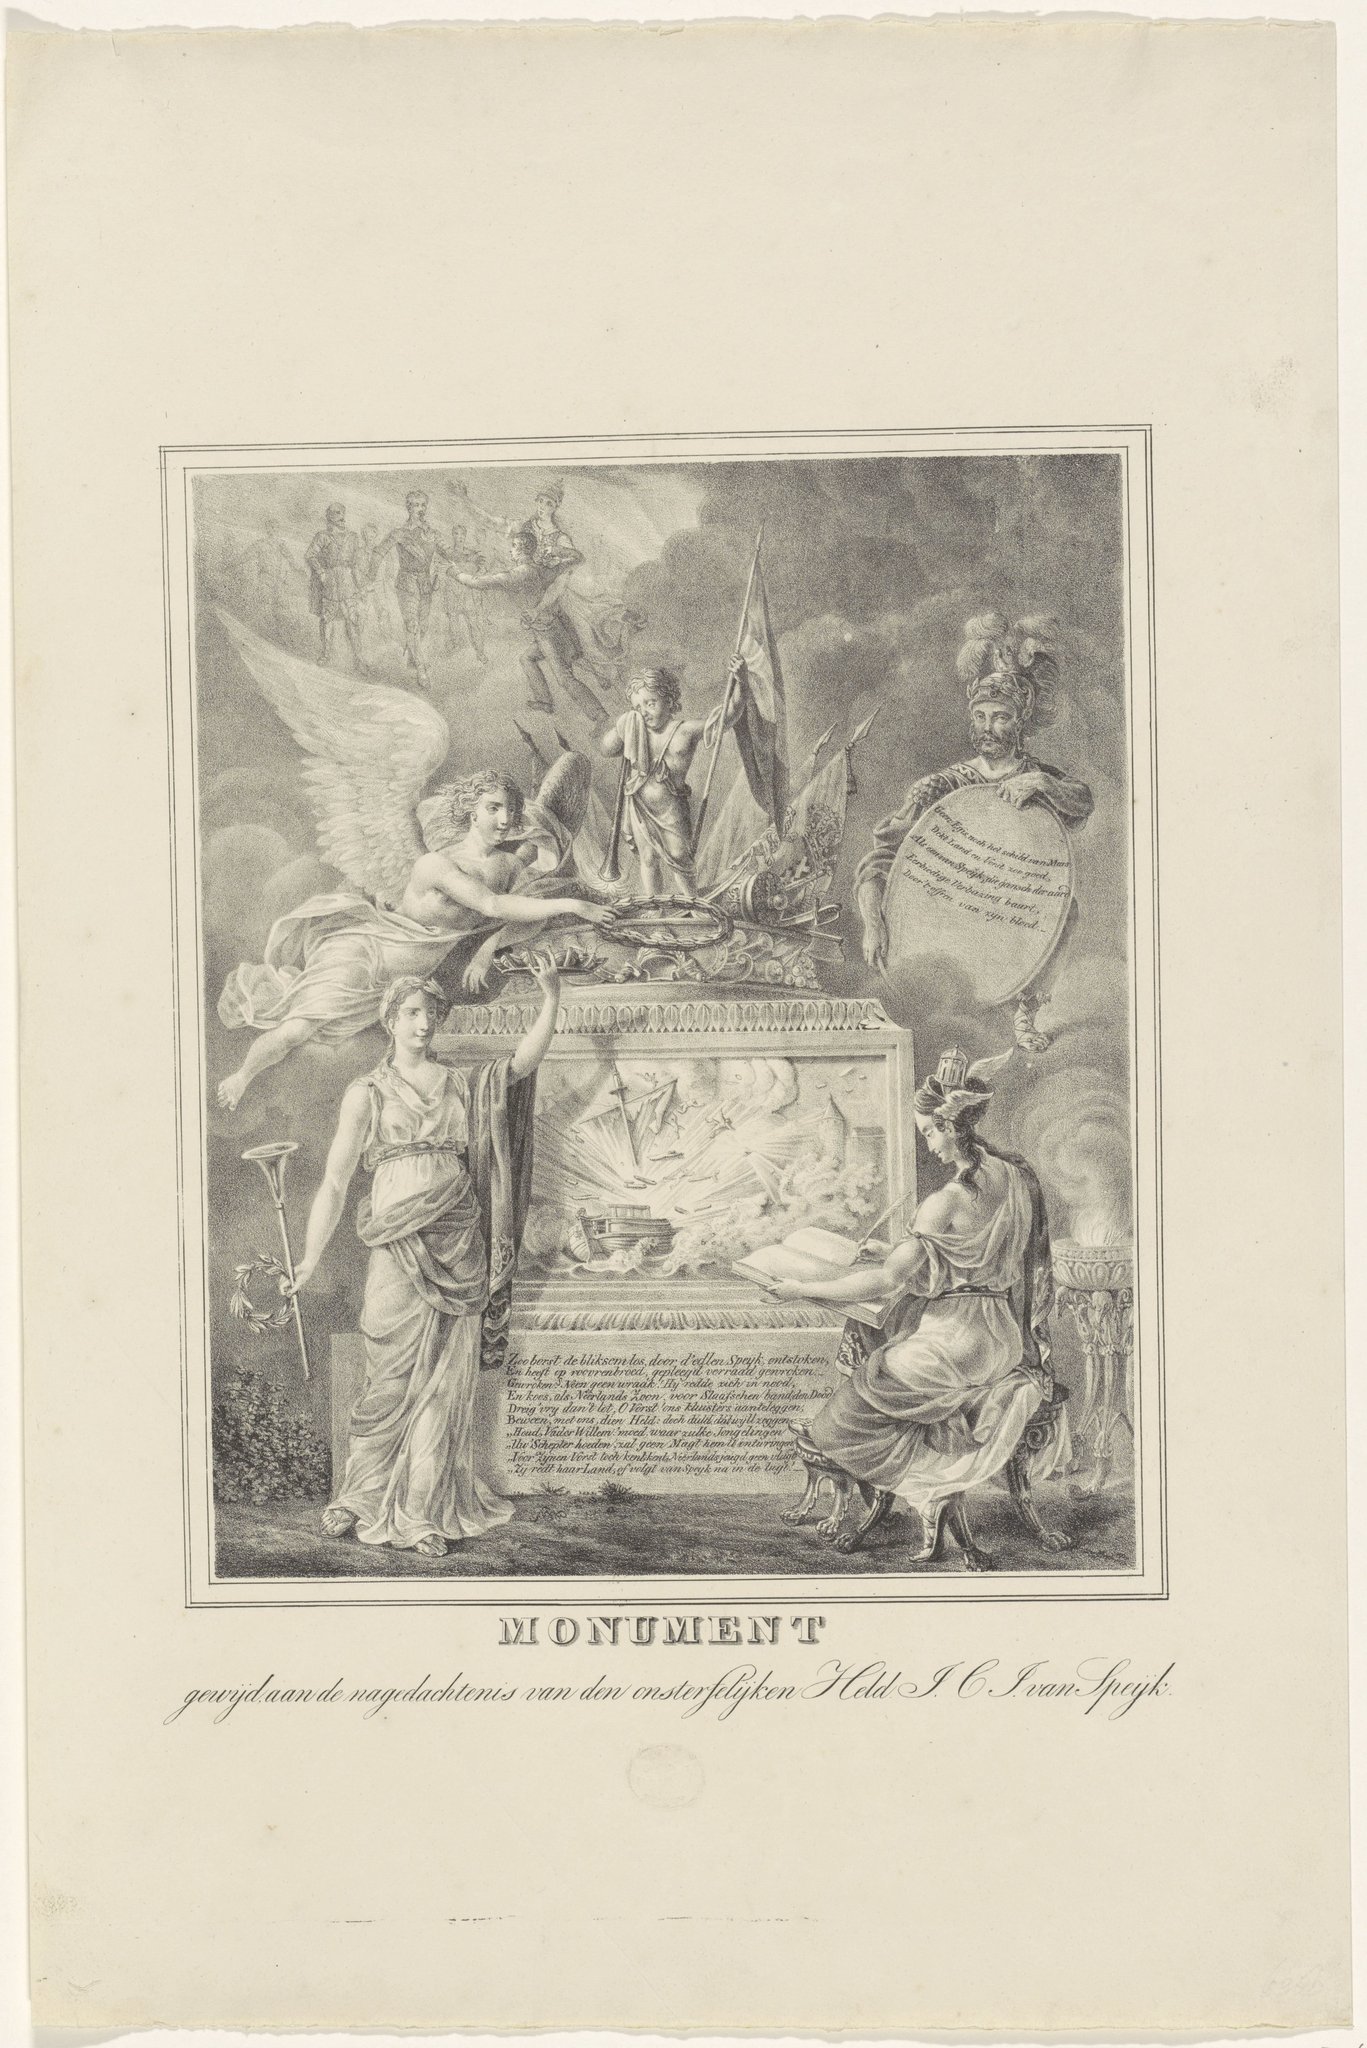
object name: print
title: Allegorisch grafmonument voor Jan van Speyk, 1831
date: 1831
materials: paper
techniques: lithograph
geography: netherlands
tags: amsterdam, antwerp, jan van speyk, 'historia'; 'historia' (ripa), fame; 'fama', 'fama buona', 'fama chiara' (ripa), navy (+ sailing-ships), self-sacrifice, death in the service of a higher purpose, gunpowder disaster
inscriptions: collector's mark: ‘E P’, collector's mark: Lugt 2228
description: Allegorisch grafmonument voor Jan van Speyk, met een voorstelling van het in de lucht springen van de kanonneerboot van Jan van Speyk op de Schelde voor Antwerpen op 5 februari 1831. Links naast het monument de Faam met bazuin en schepenkroon, rechts schrijft Clio de geschiedenis. Een engel (Victorie?) brengt een lauwerkrans, op het graf een huilende genius met de Nederlandse vlag. Rechts in de lucht Mars, linksboven wordt Van Speyk in de hemel ontvangen door onsterfelijke helden. Op de voetstuk van het monument een tienregelig vers.